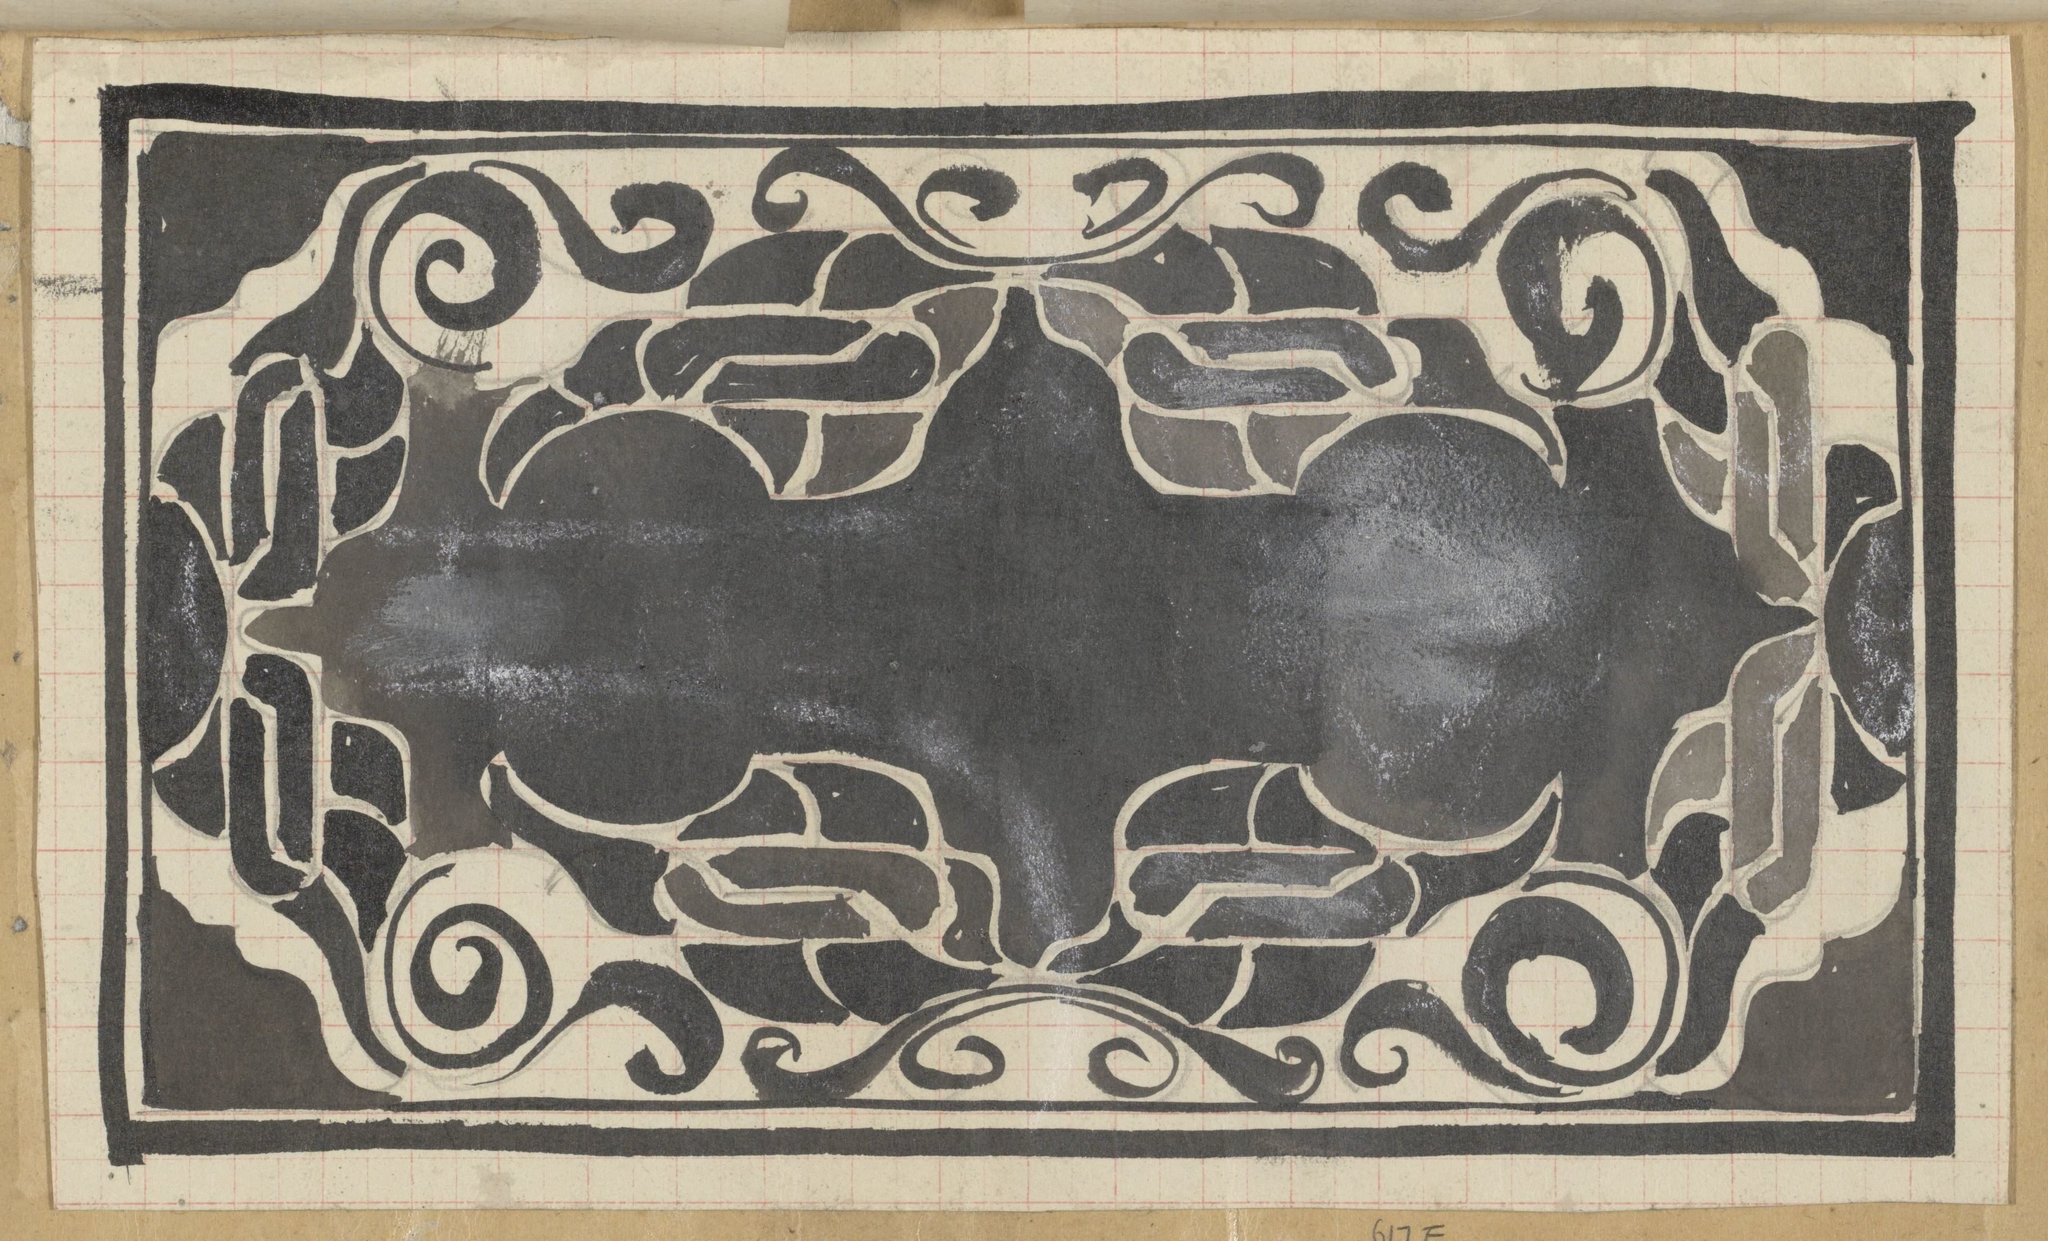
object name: design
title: Decoratief ontwerp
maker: carel adolph lion cachet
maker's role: draughtsman, print maker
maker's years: 1864-1945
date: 1874-1945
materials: pencil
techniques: brush